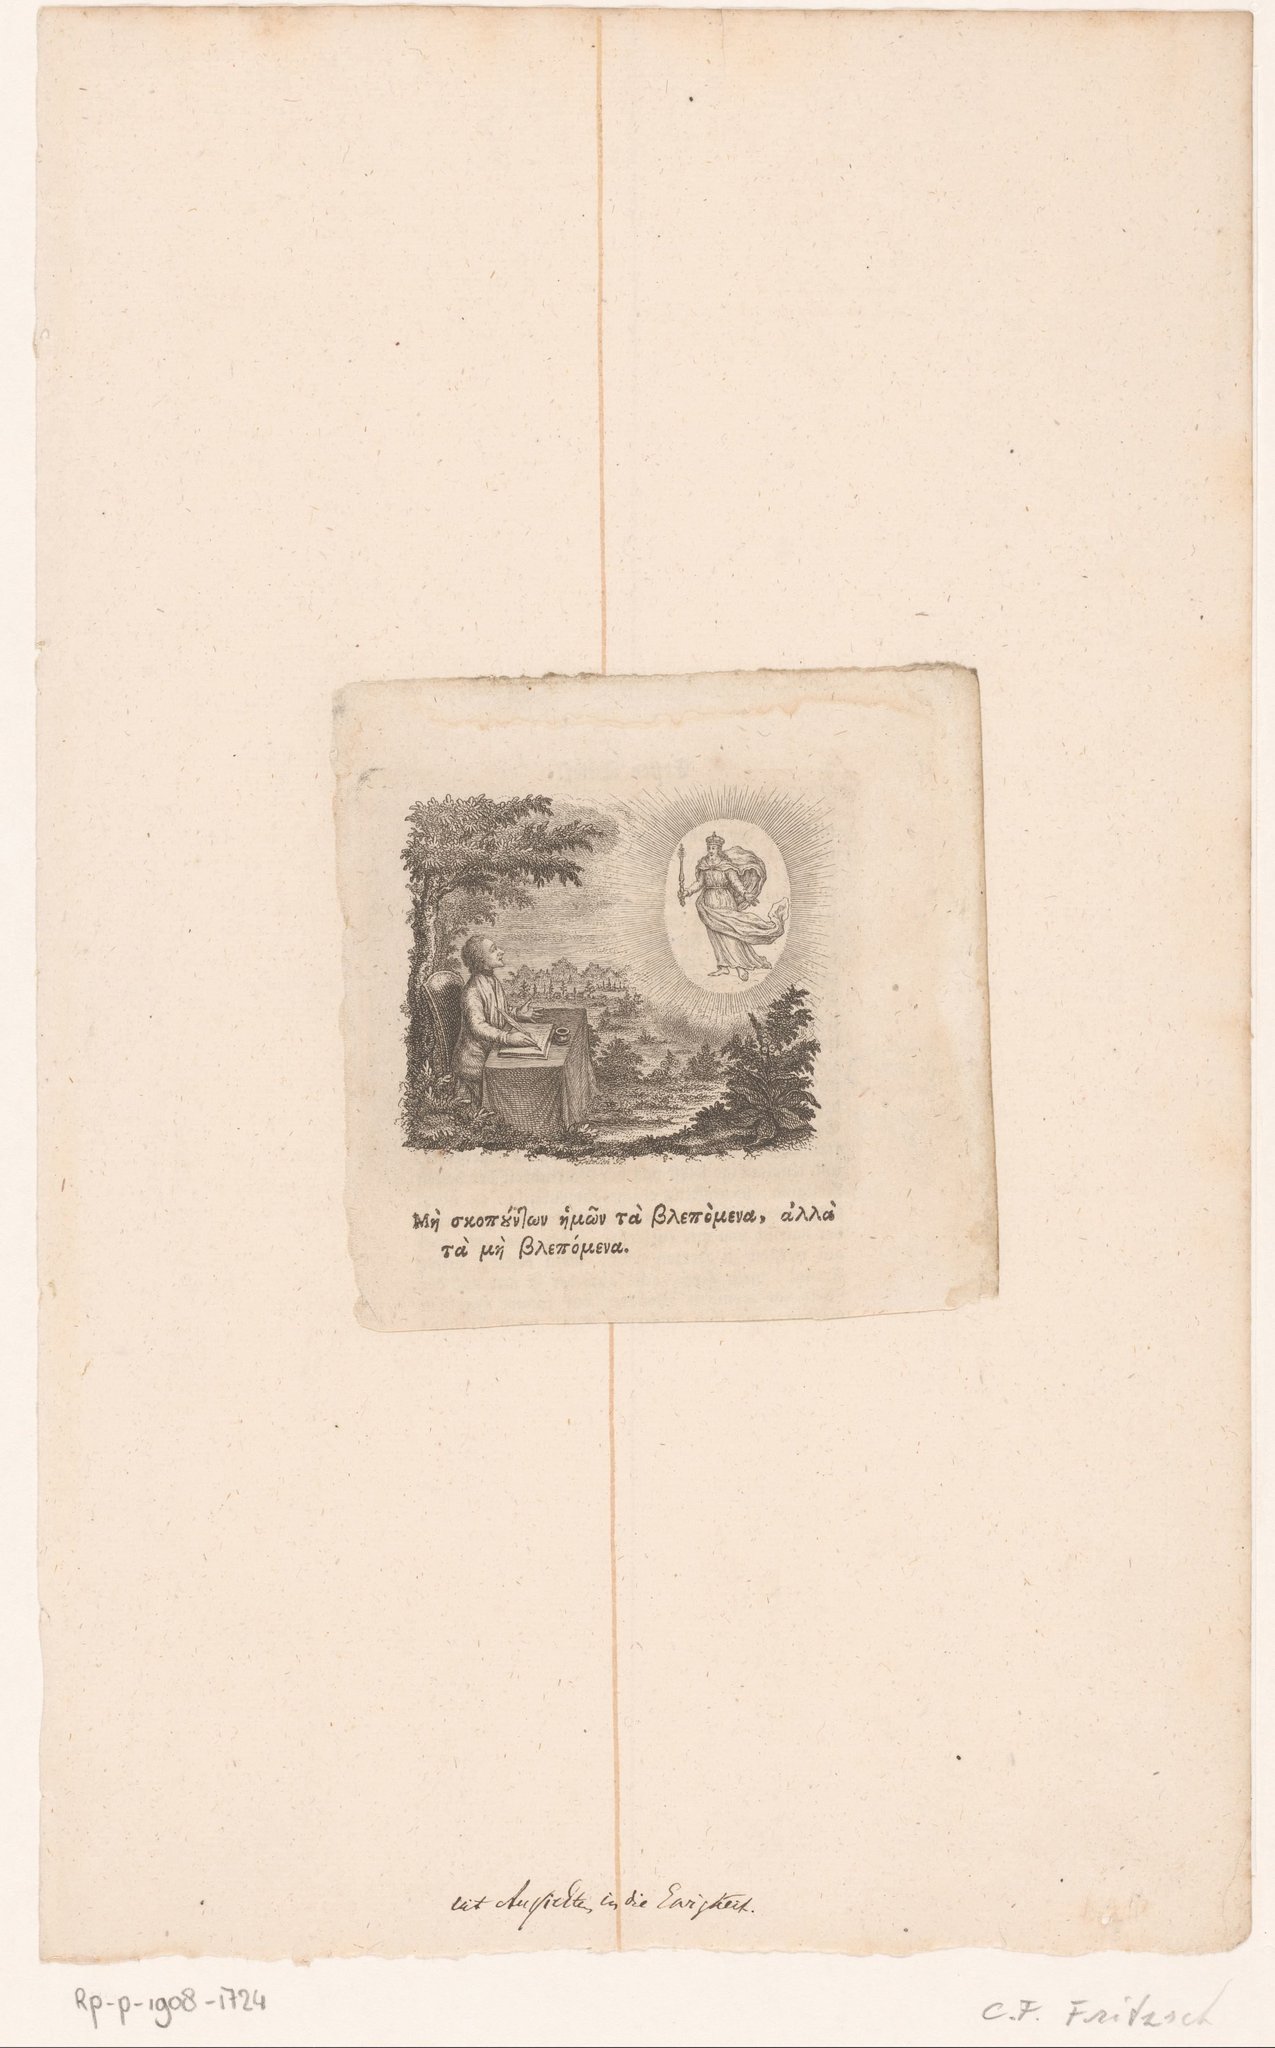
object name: print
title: God verschijnt in een visioen aan Johann Kaspar Lavater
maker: christian friedrich fritzsch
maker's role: print maker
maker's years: 1719-1774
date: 1773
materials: paper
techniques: engraving, letterpress printing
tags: johann caspar lavater, landscapes, god the father, historical persons, vision, author, poet writing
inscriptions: collector's mark: Lugt 2228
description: Prent uit: Lavater, Johann Kaspar. Aussichten in die Ewigkeit, in Briefen an Joh. Georg Zimmermann. Hamburg: s.n., 1773.